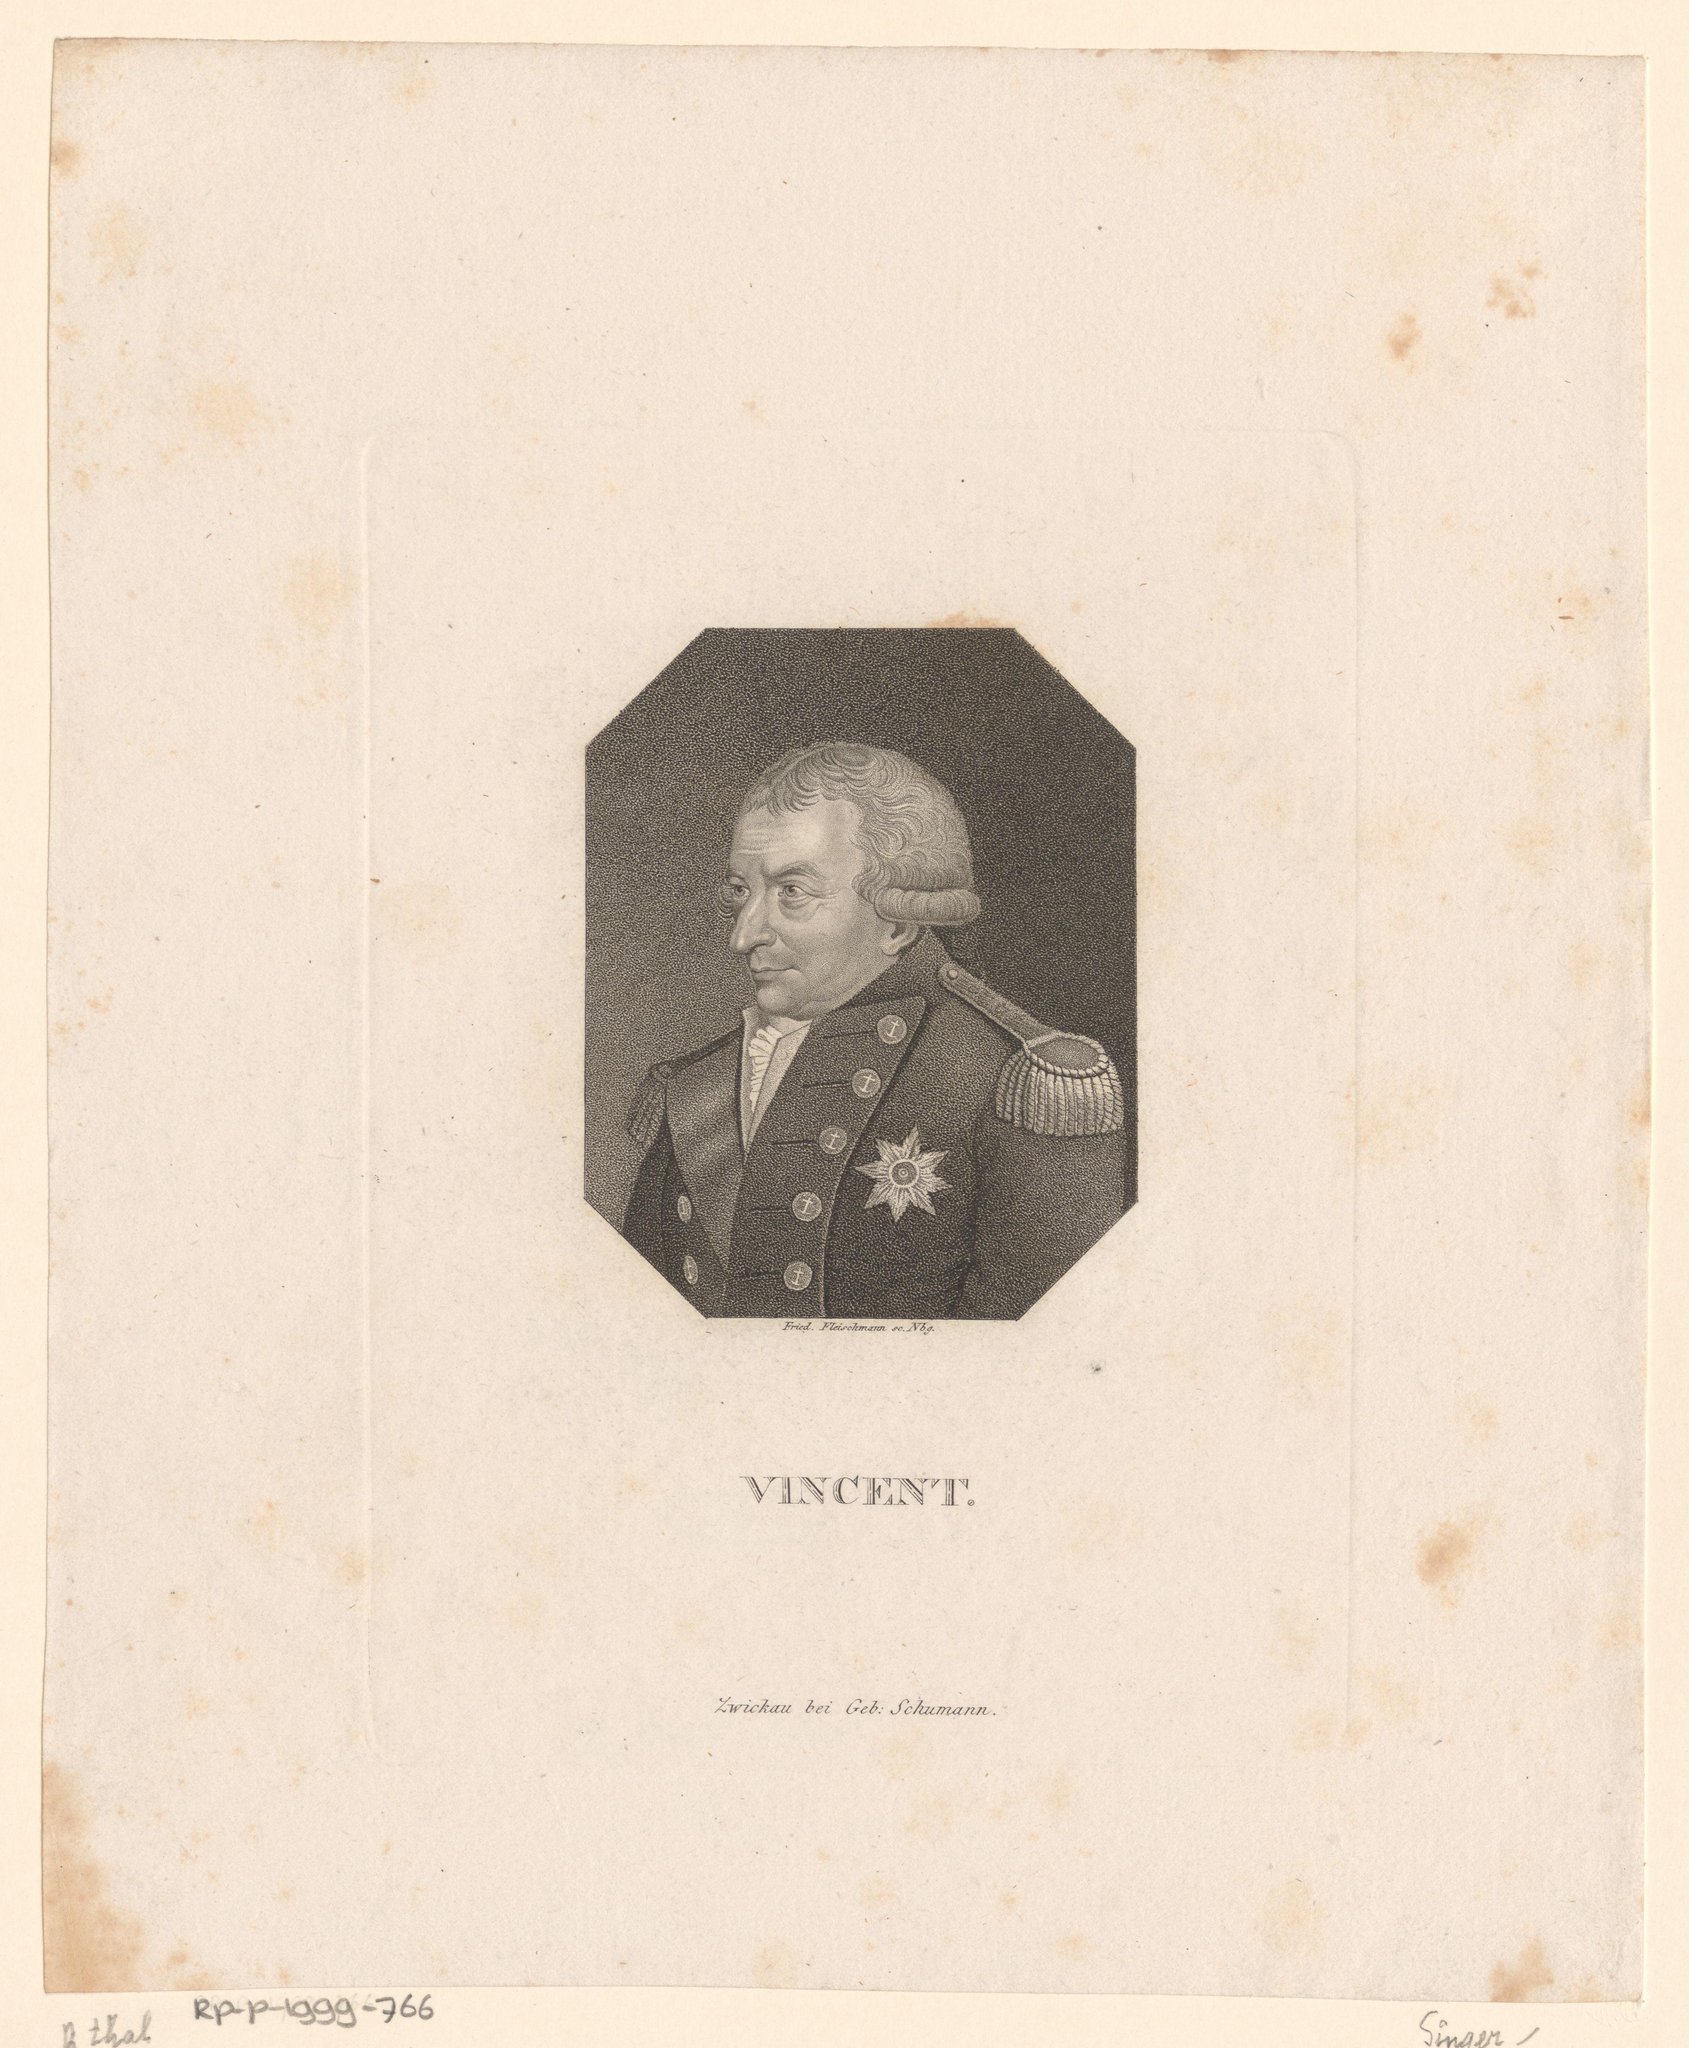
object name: print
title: Bildnisse der berühmtesten Menschen aller Völker und Zeiten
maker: friedrich fleischmann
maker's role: print maker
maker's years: 1791-1834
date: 1818-1832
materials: paper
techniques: etching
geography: zwickau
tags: historical persons, commander-in-chief, admiral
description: Prent uit: 'Bildnisse der berühmtesten Menschen aller Völker und Zeiten' van de gebroeders Schumann, uitgegeven in 1818-1832 te Zwickau.